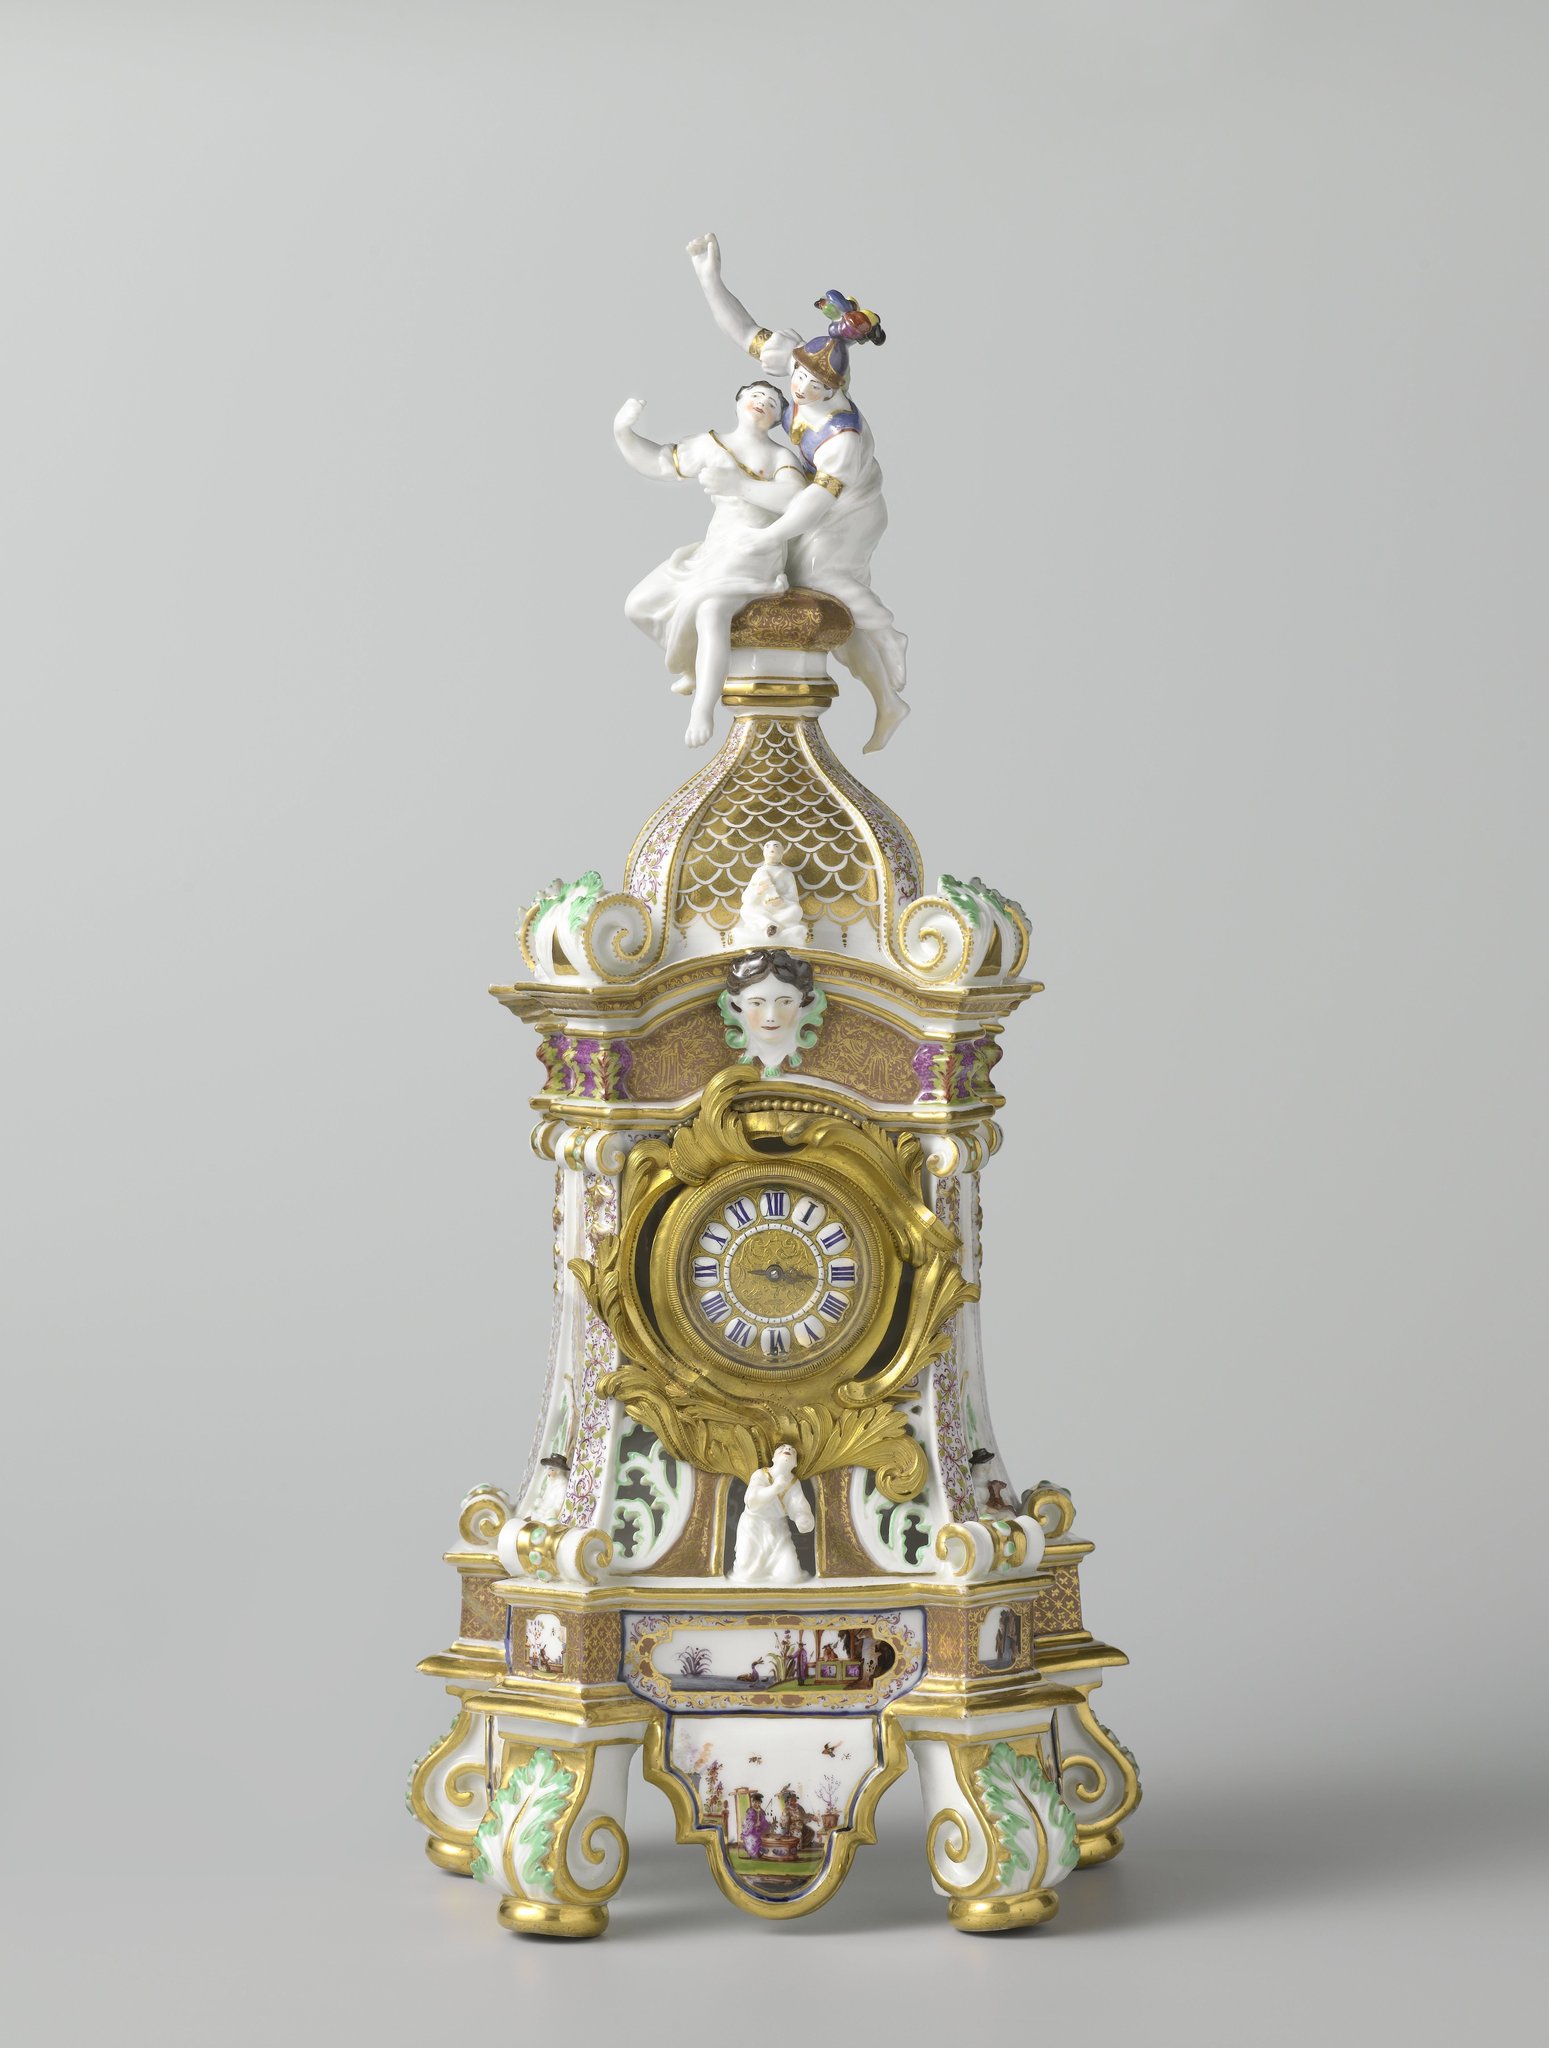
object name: schoorsteenklok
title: Clock case with Arachne and Athena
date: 1727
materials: metal, porcelain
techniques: gilding, painted, vitrification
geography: paris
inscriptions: number: ‘135’, signature: ‘Barrey à Paris’, factory mark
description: This clock case is one of the Meissen porcelain factory’s most ambitious models from its early years. It is a piece of furniture executed in porcelain and designed as a small building. The two women crowning it represent the weaver Arachne and the goddess Athena. Athena was so jealous of Arachne’s skill that she transformed her into a spider.